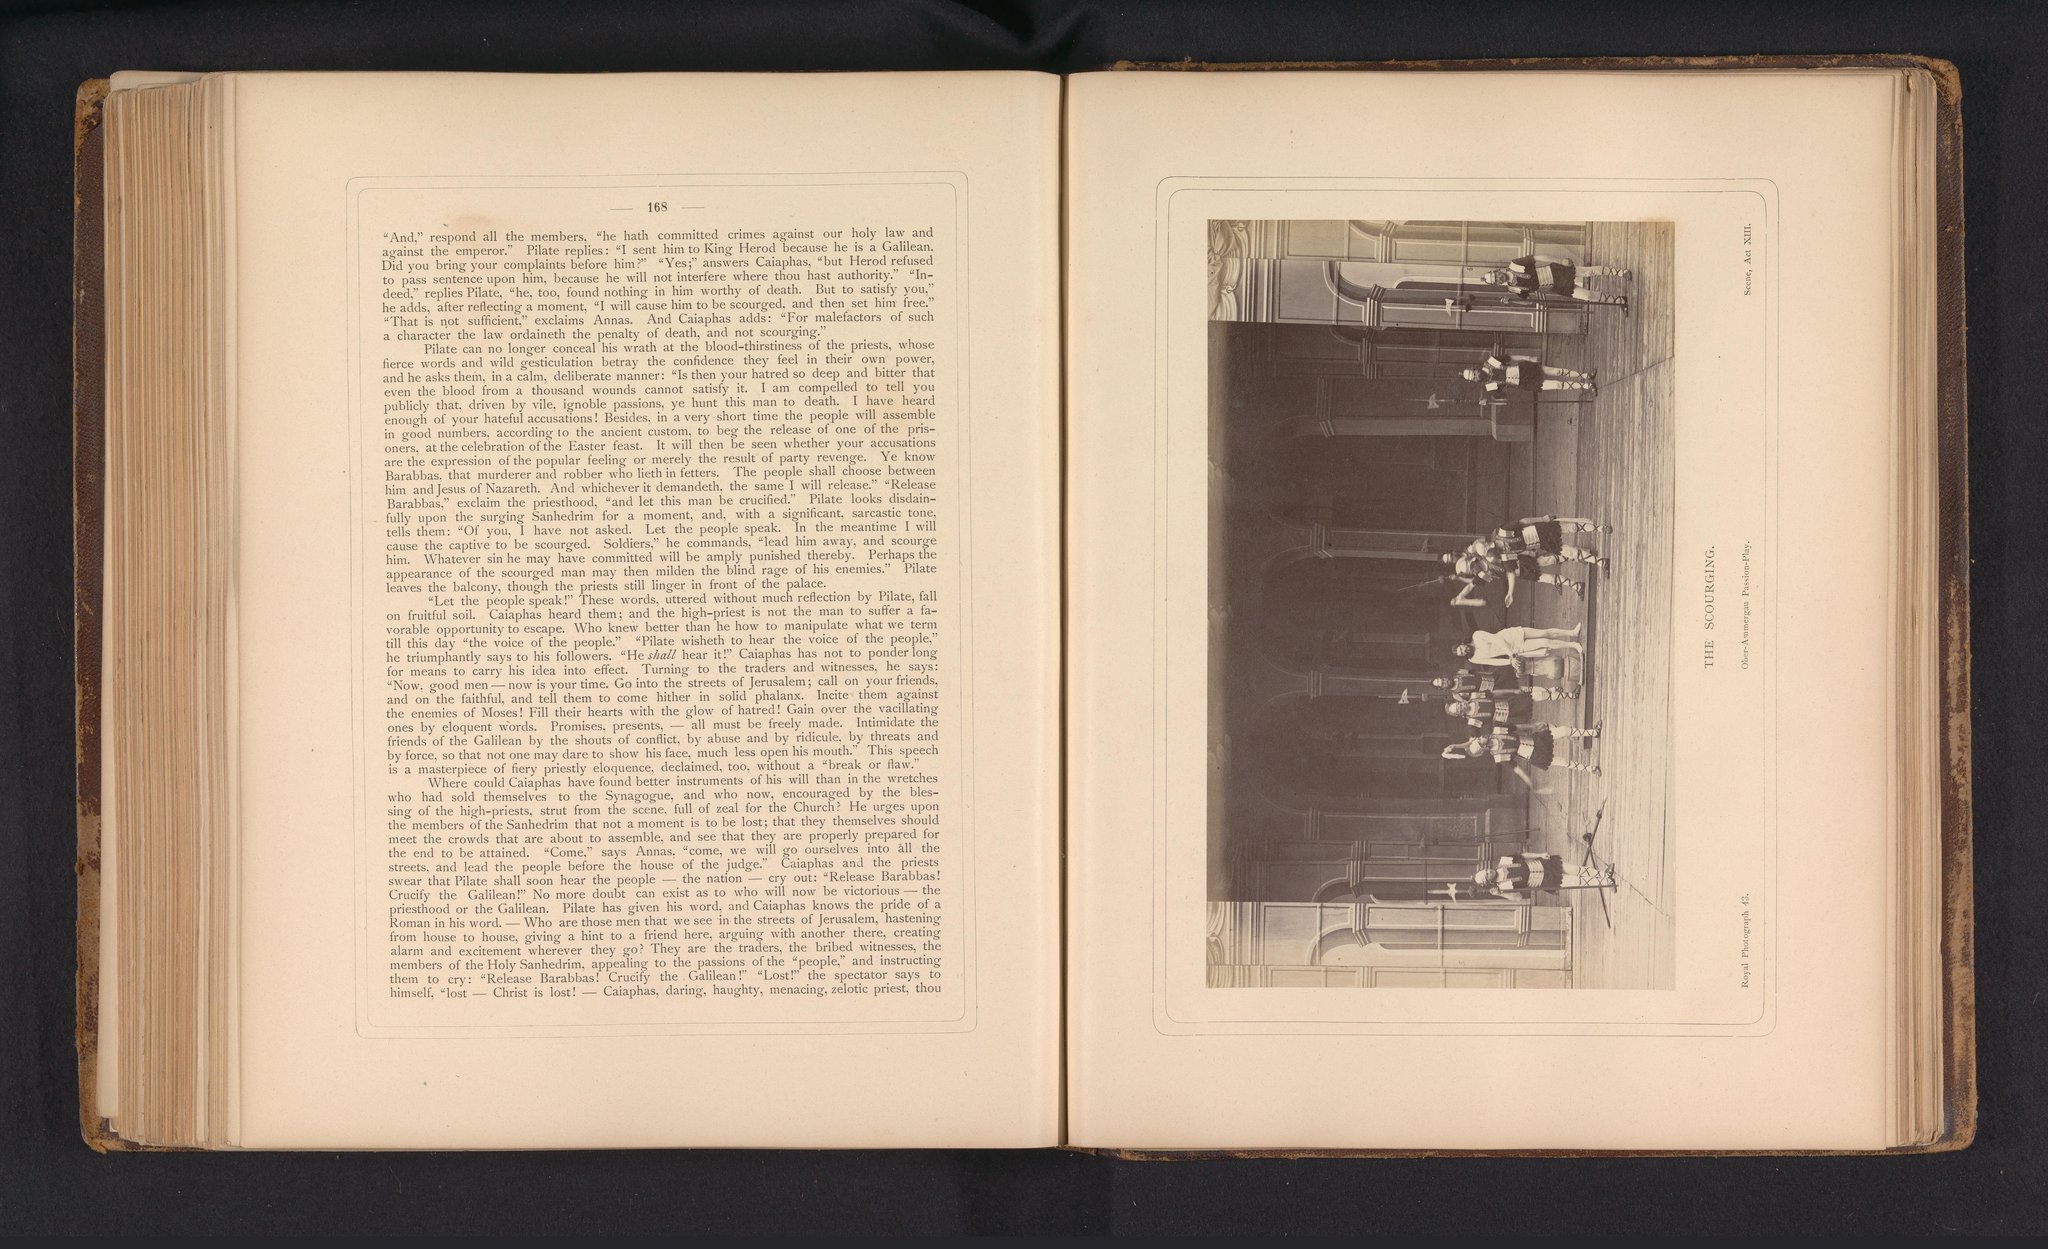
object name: page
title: The scourging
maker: joseph albert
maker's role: printer, publisher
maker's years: 1825-1886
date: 1868-1873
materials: photographic support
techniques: albumen print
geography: oberammergau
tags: group of actors, troupe; actors on the stage, flagellation by soldiers, christ usually tied to a column (matthew 27:26; mark 15:15; john 19:1)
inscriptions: number: ‘Royal Photograph 43.’